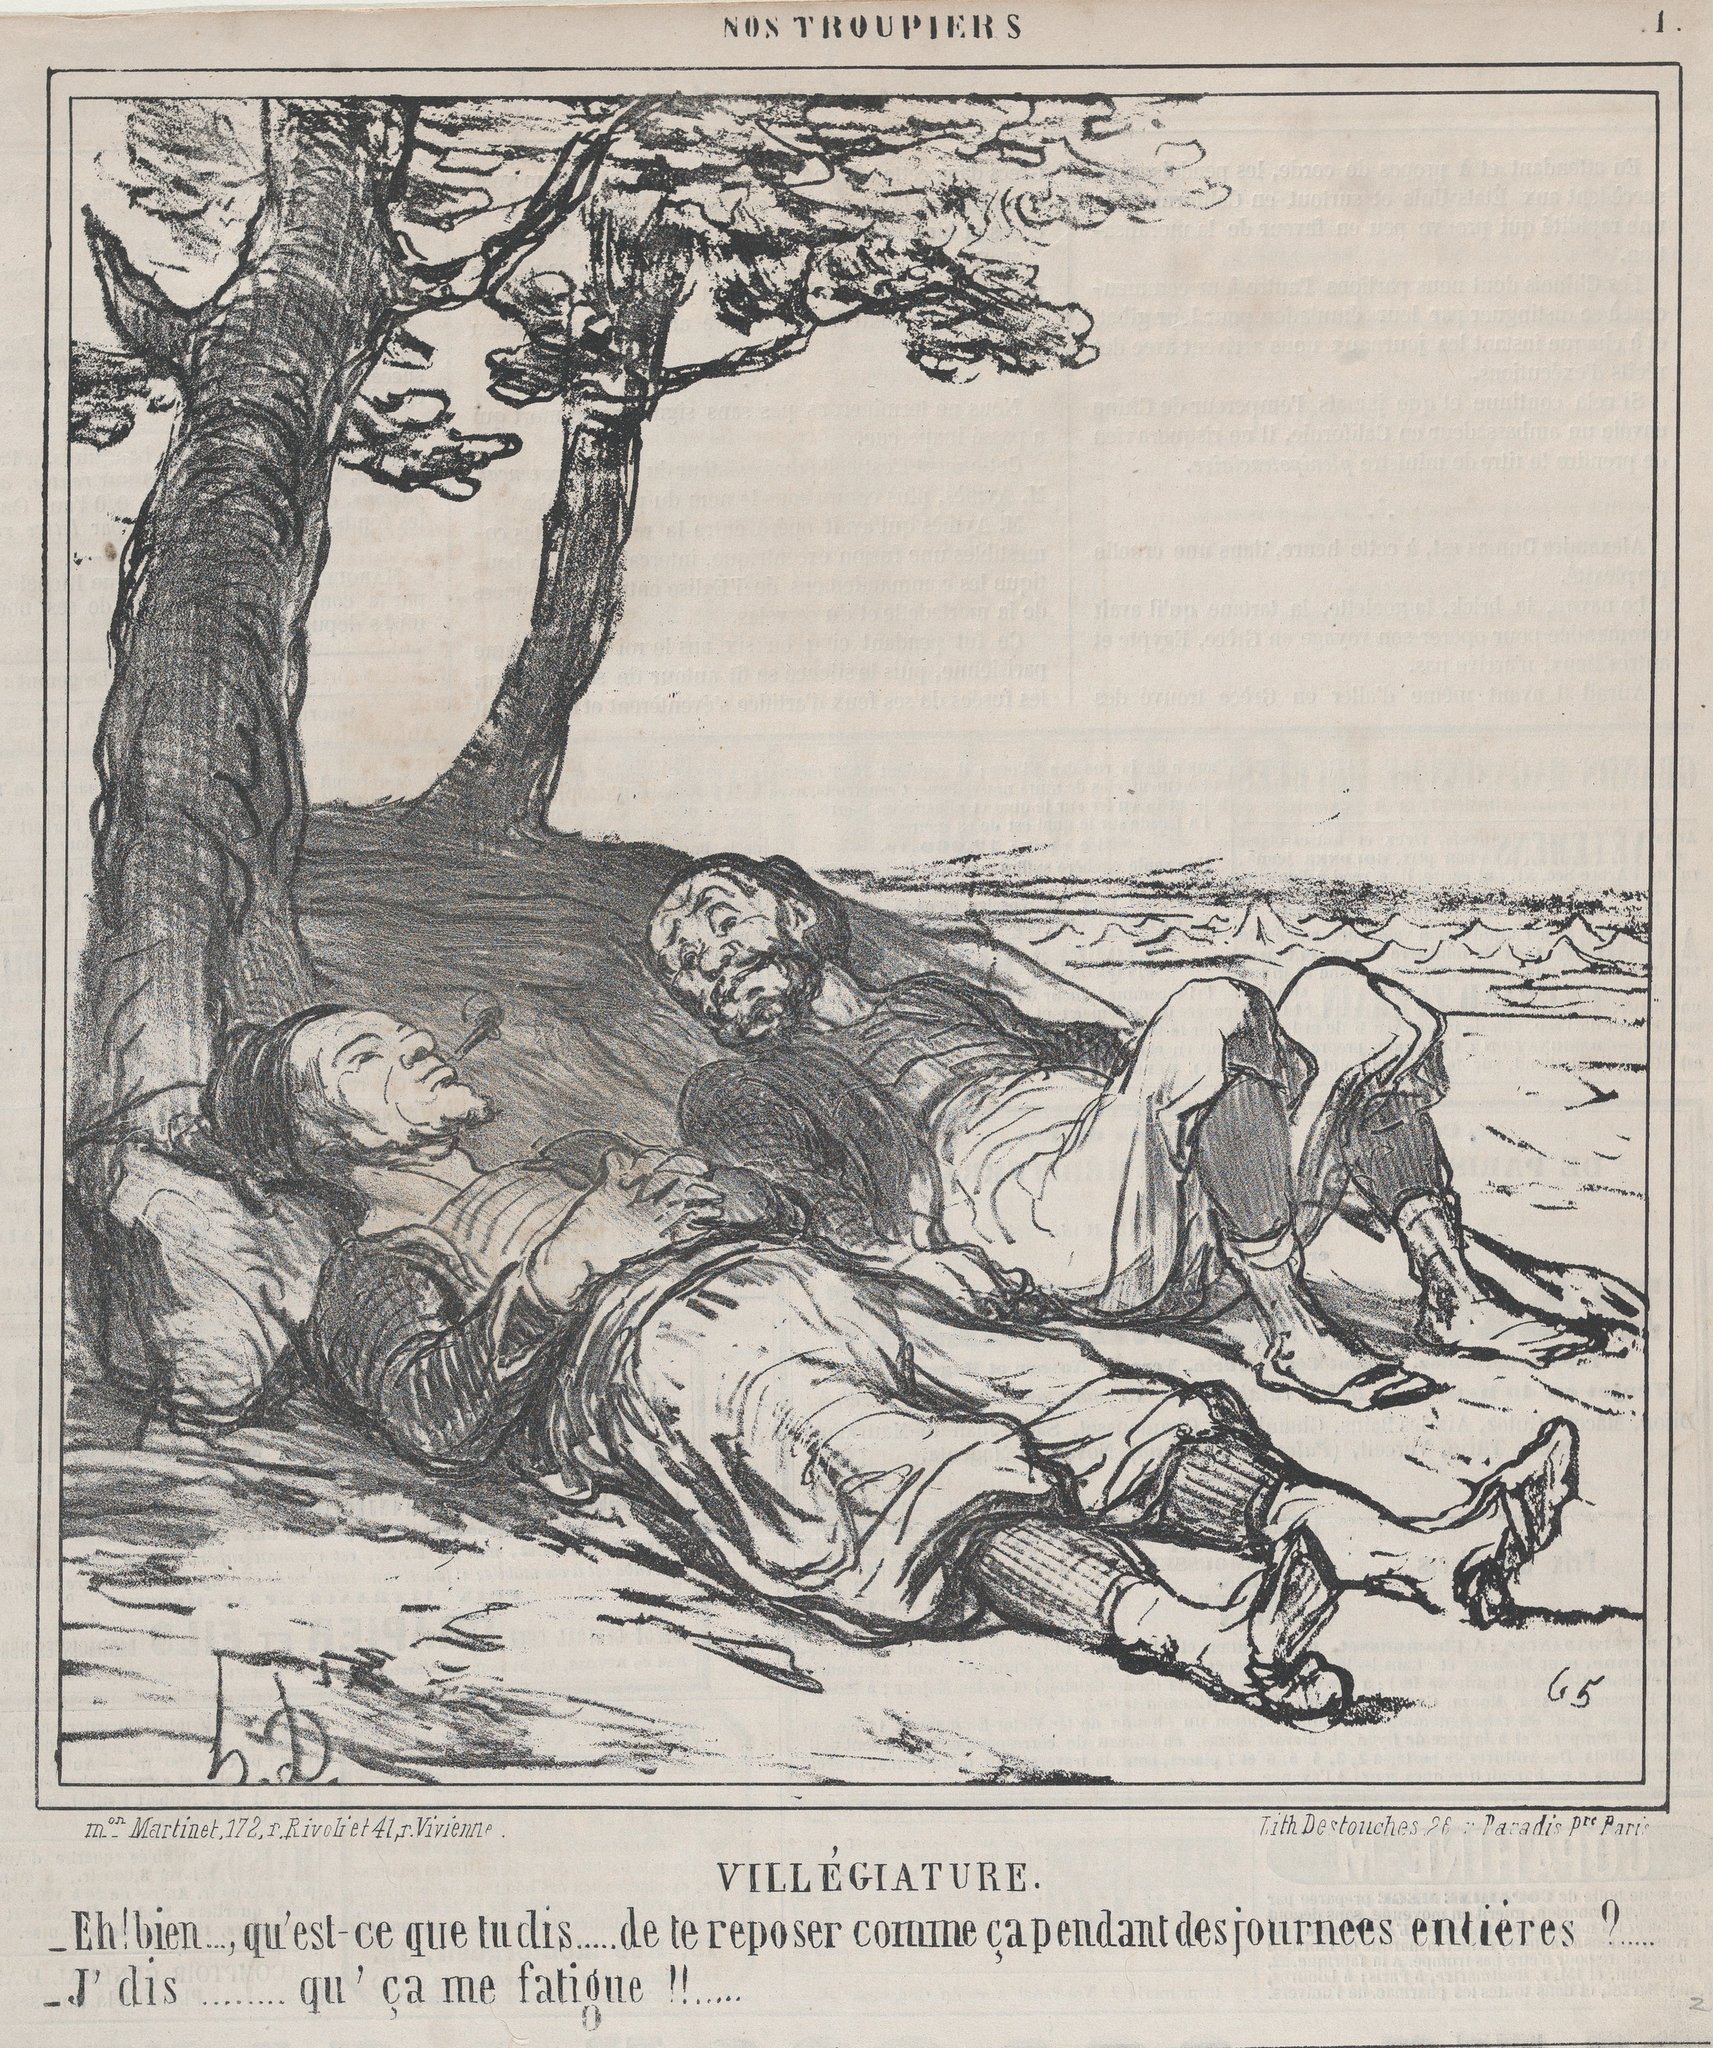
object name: print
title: Villégiature, from Nos Troupiers, published in Le Charivari, July 26, 1859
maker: honoré daumier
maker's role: artist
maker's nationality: french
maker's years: 1808-1879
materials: paper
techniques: lithograph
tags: men,trees